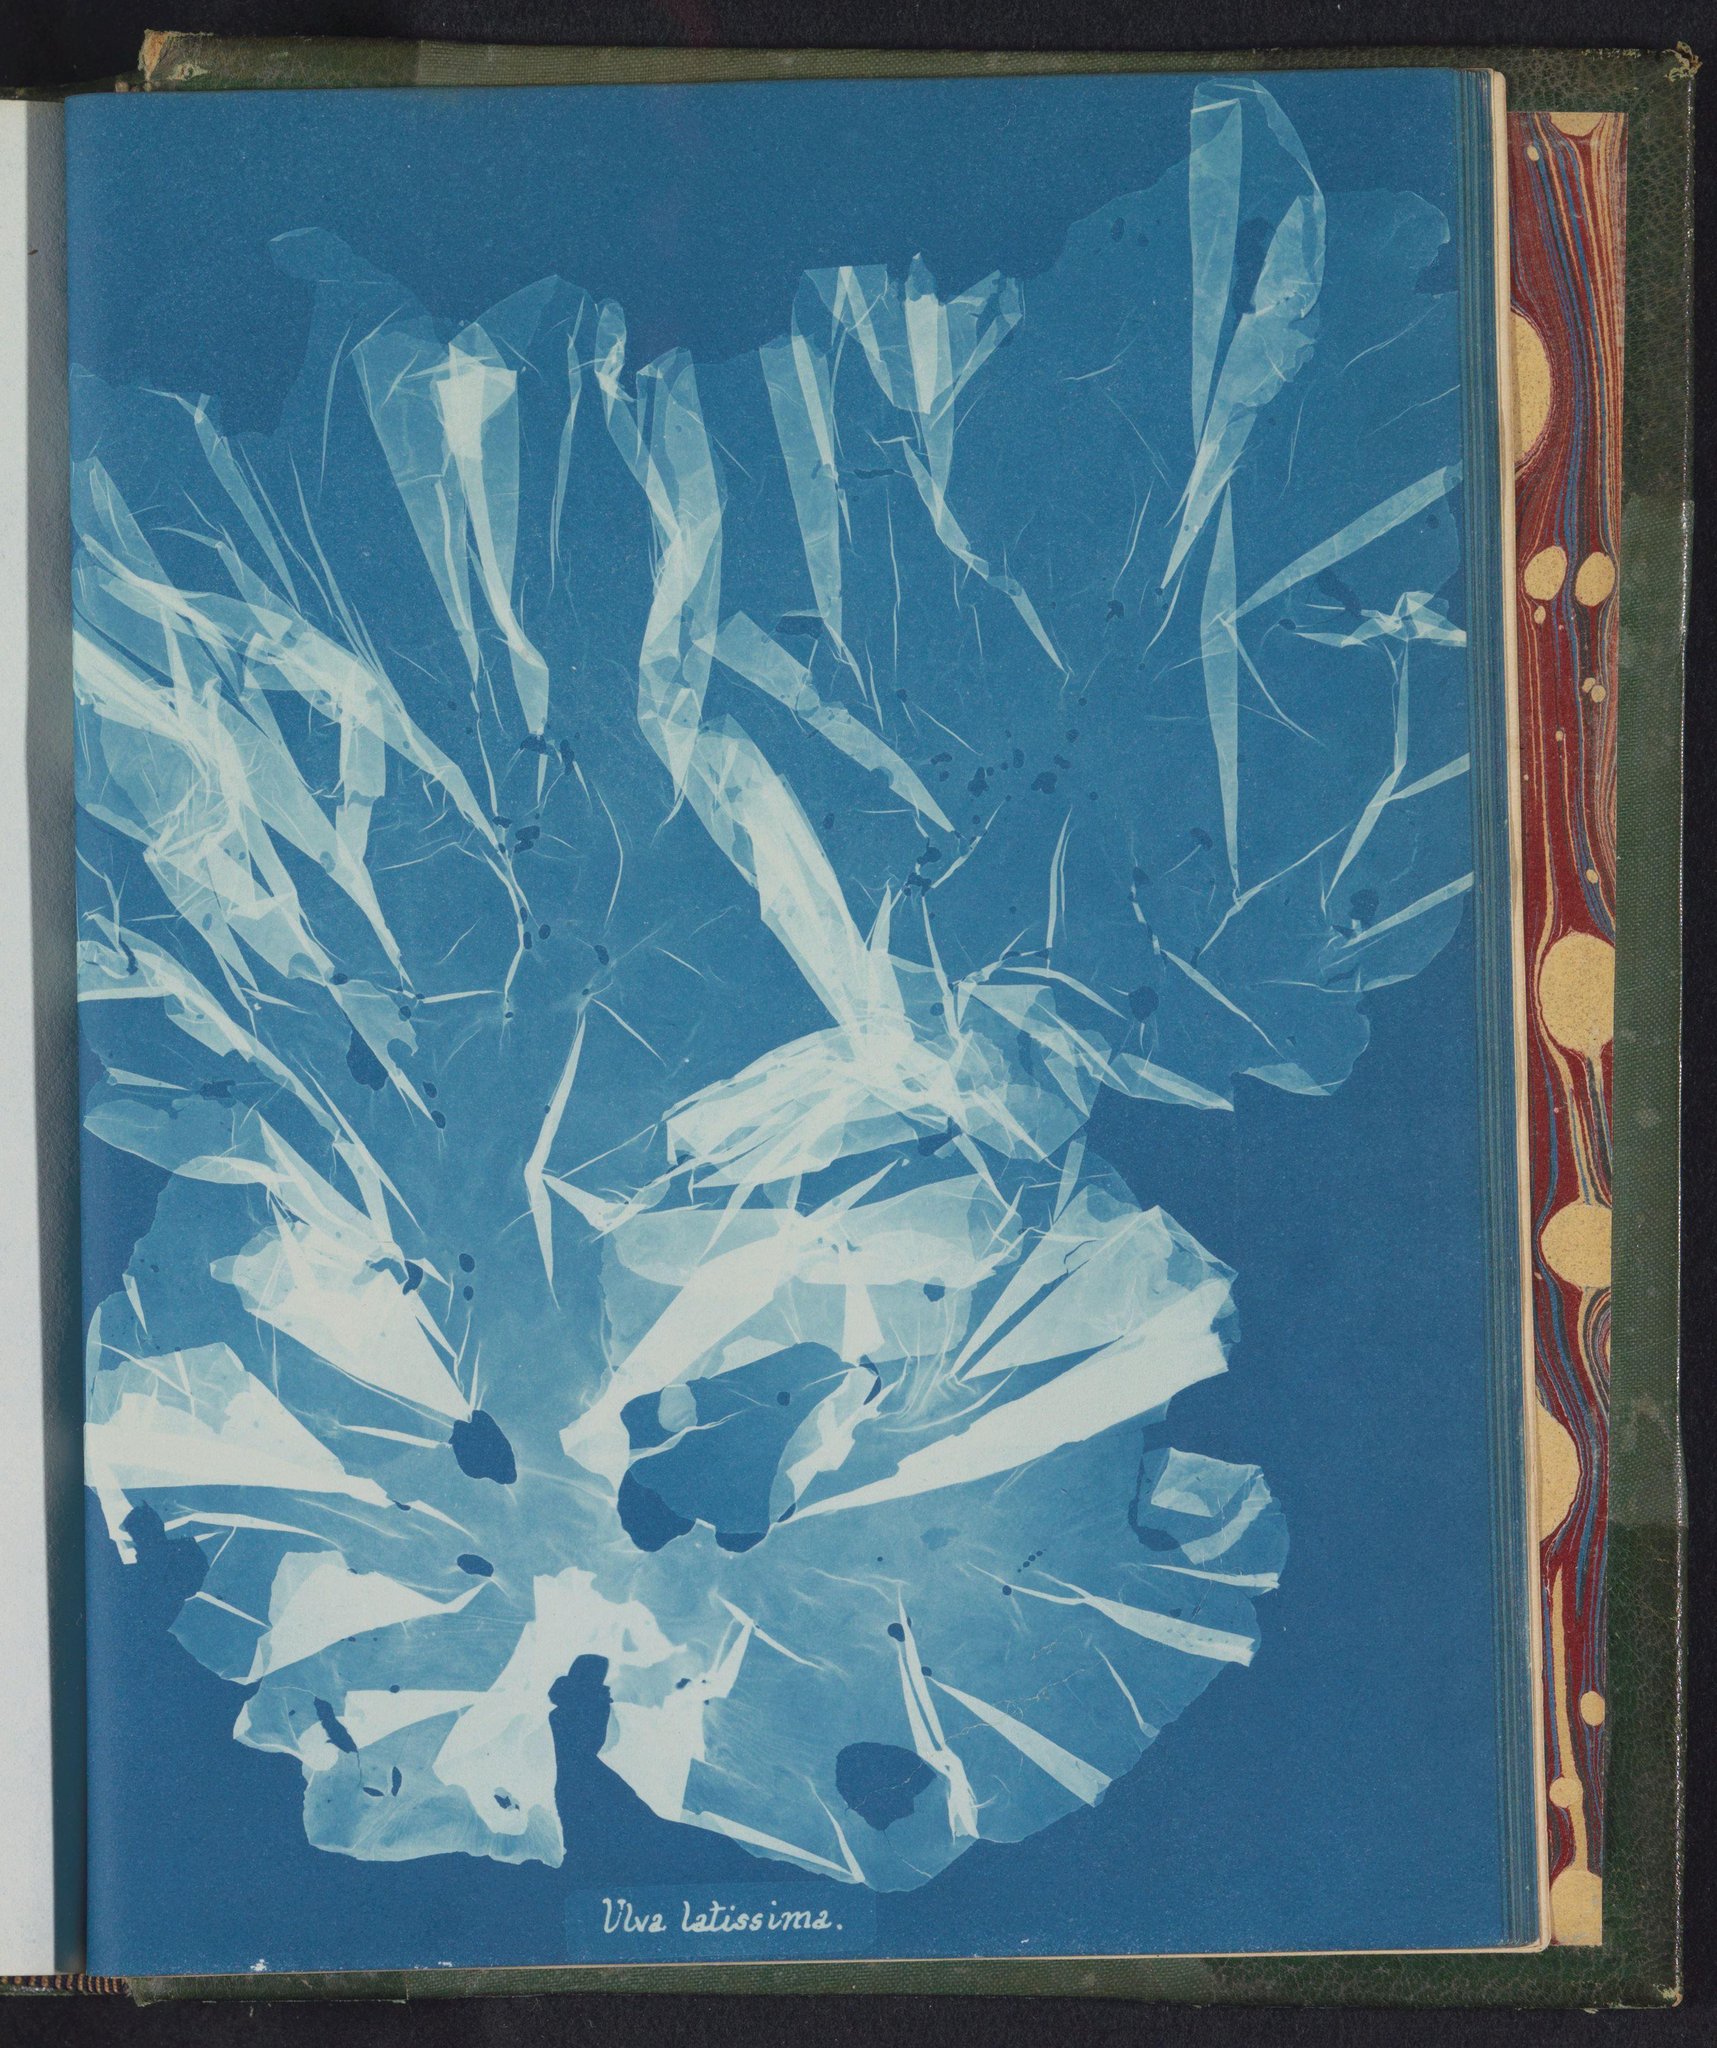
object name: page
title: Ulva latissima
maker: anna atkins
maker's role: fotograaf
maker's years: 1799-1871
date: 1843-1853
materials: photographic support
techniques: cyanotype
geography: united kingdom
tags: algae, seaweed